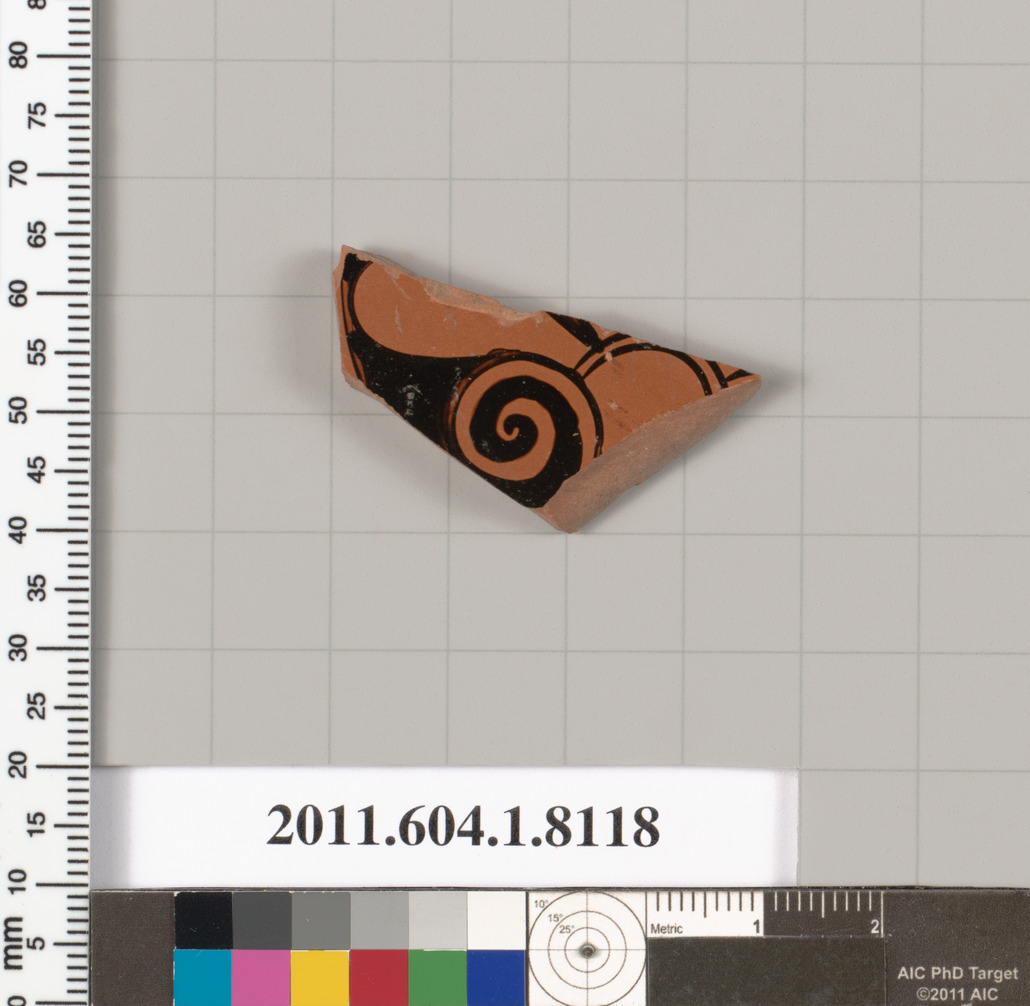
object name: kylix fragment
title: Terracotta fragment of a kylix (drinking cup)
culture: greek, attic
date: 534-468 BCE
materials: terracotta